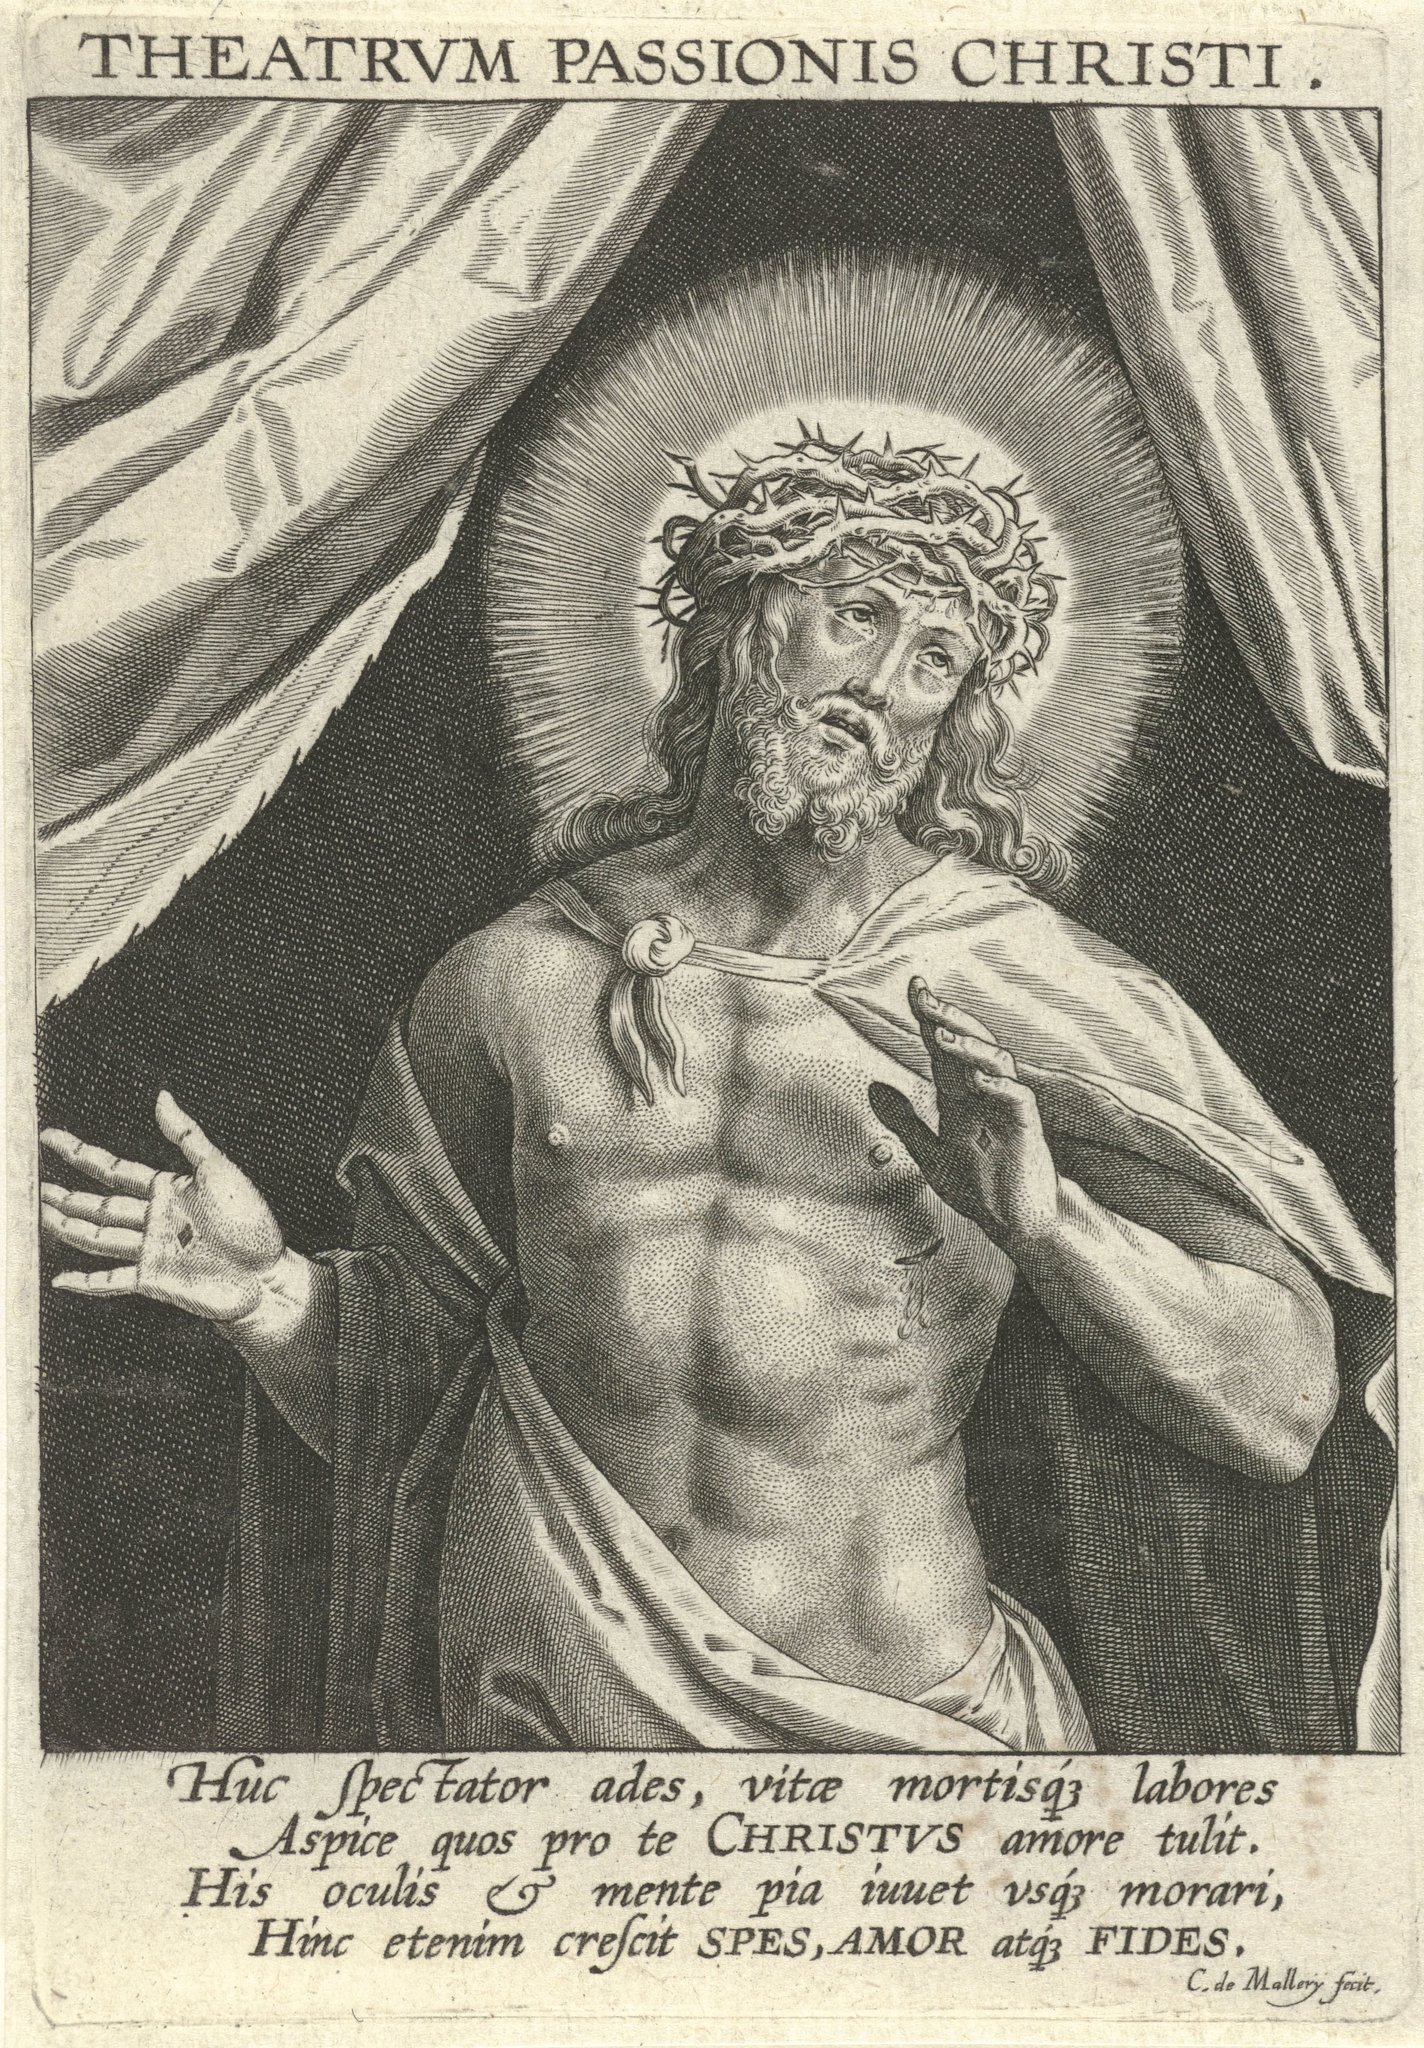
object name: print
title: Christus en zeven engelen met de Passiewerktuigen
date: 1581-1645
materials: paper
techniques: engraving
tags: man of sorrows, 'imago pietatis', 'erbärmdebild', 'schmerzensmann'; the upright christ showing his wounds, usually bearing the crown of thorns, and accompanied by the instruments of the passion, standing or sitting in his tomb, passion of christ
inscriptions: collector's mark: Lugt 240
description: Christus als Man van Smarten. Onder de voorstelling vier regels in het Latijn en bovenaan de serietitel in het Latijn. Eerste prent uit een serie van zeven prenten met voorstellingen van engelen met de Passiewerktuigen.